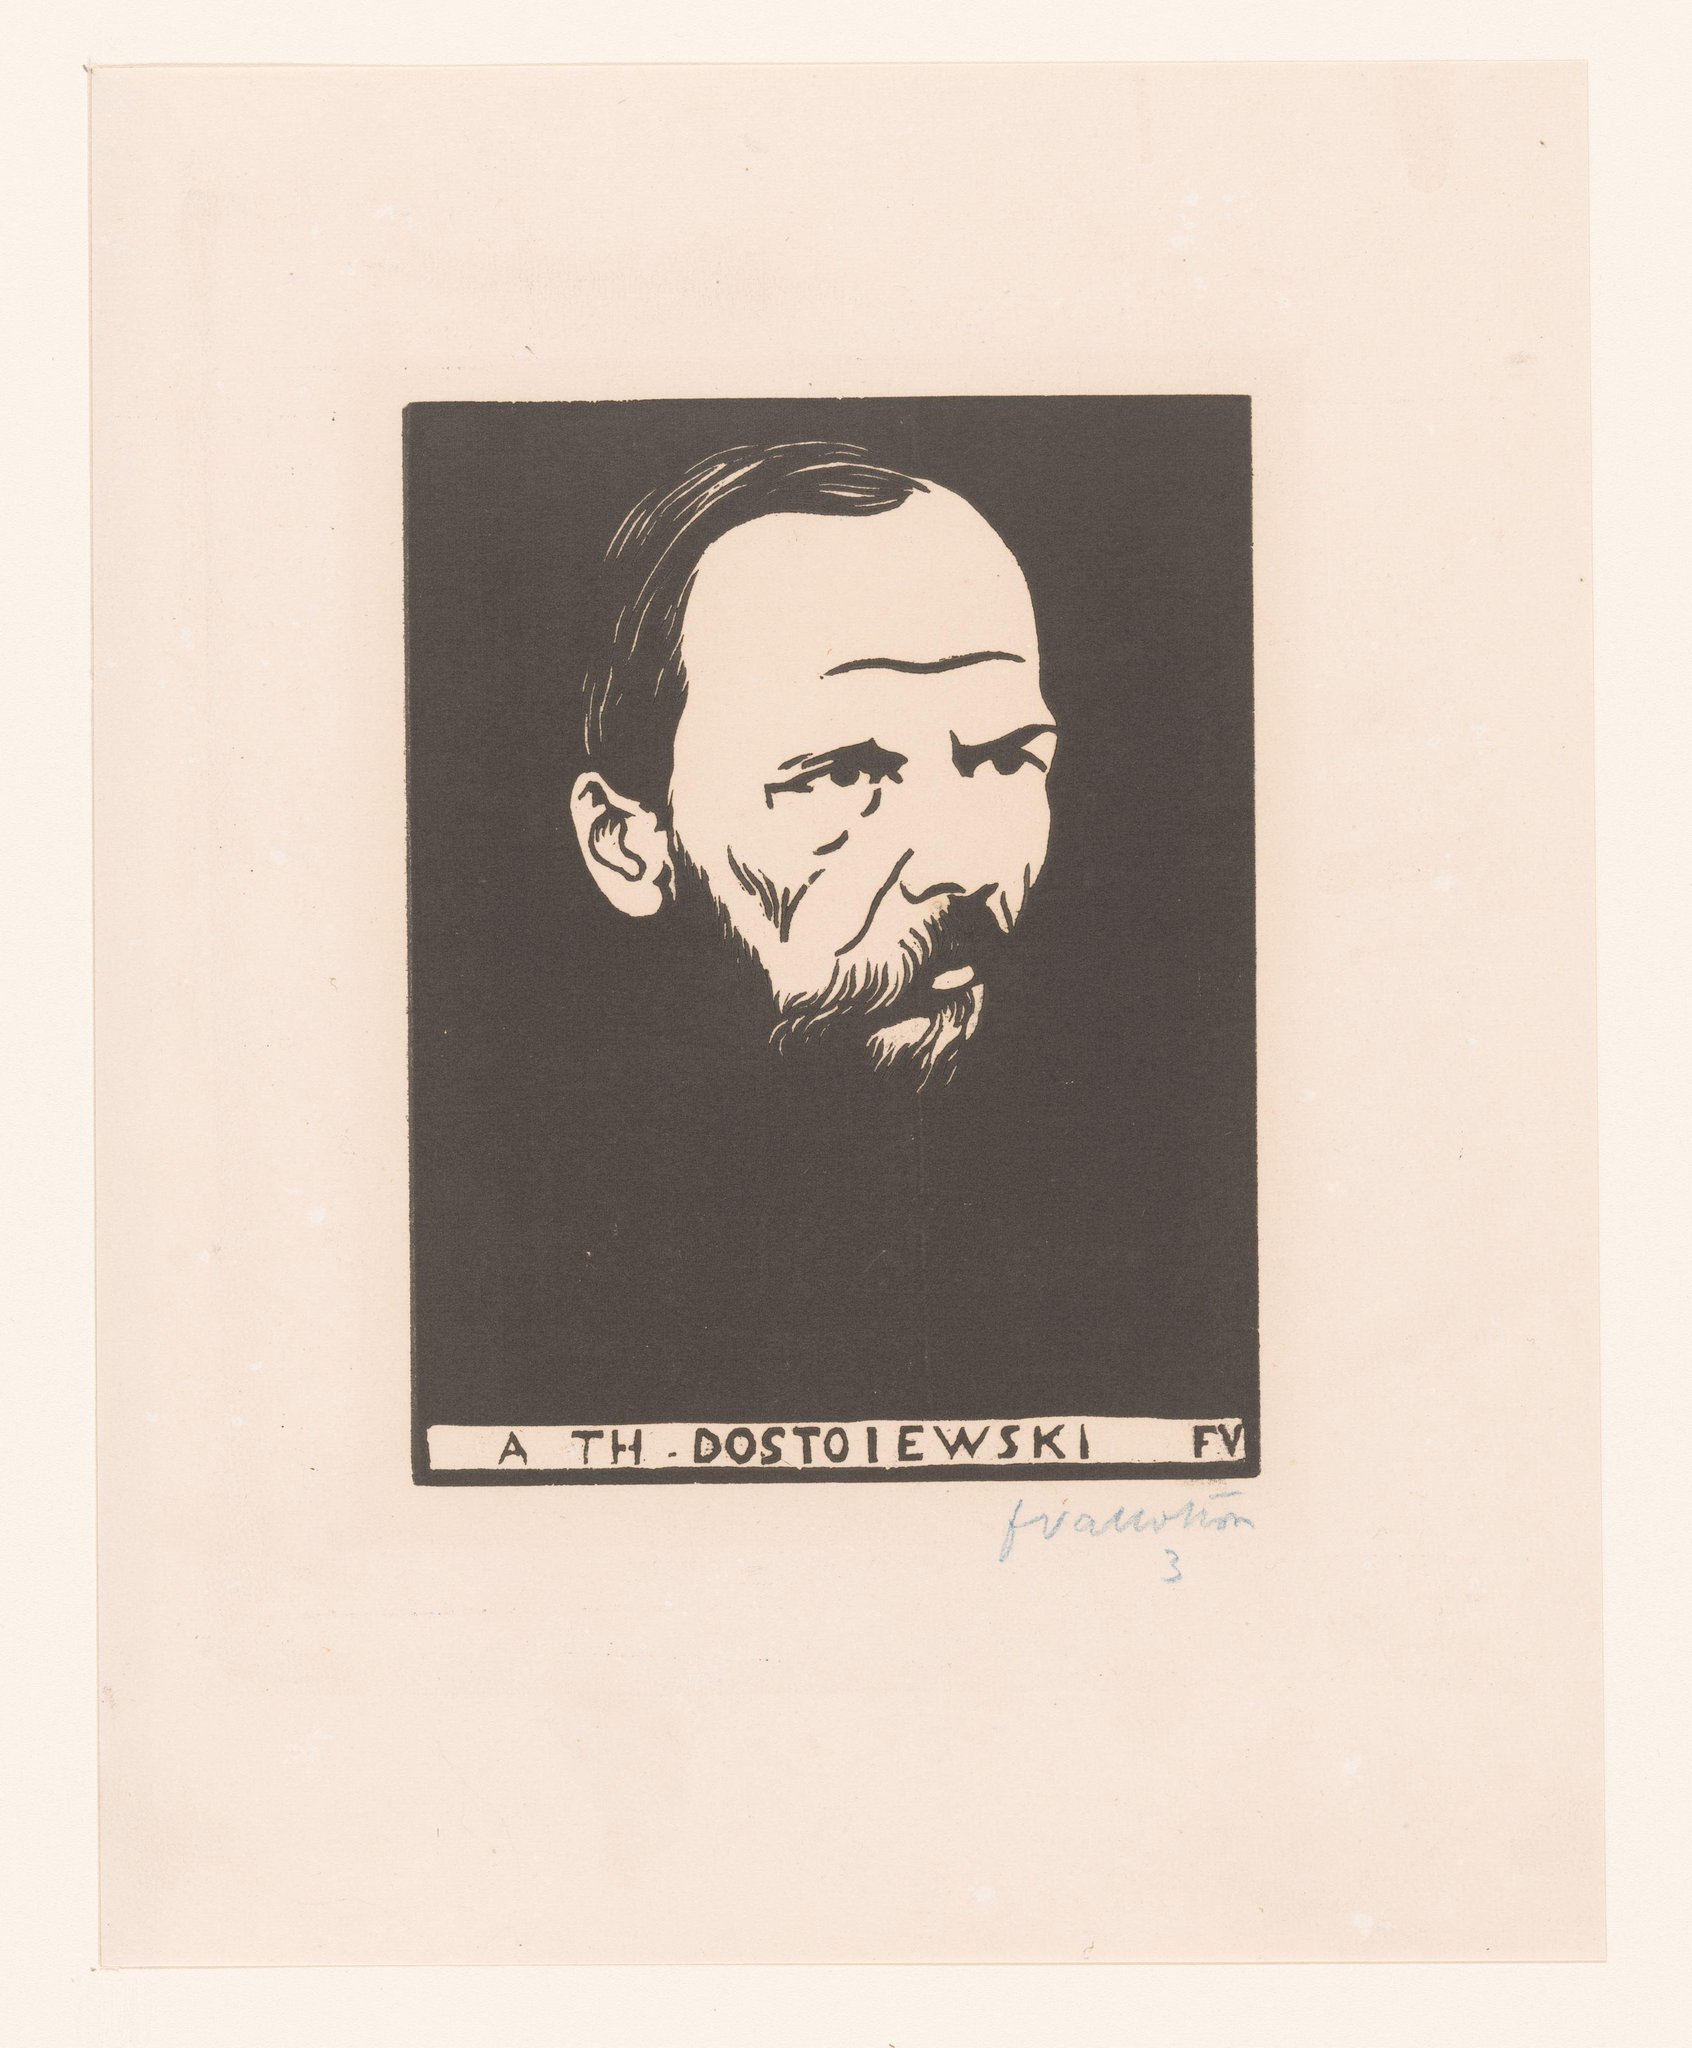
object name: print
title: A Th. Dostoiewski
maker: félix edouard vallotton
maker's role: print maker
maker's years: 1865-1925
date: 1895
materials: paper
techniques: woodcut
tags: historical persons, portrait of a writer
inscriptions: collector's mark: Lugt 2228